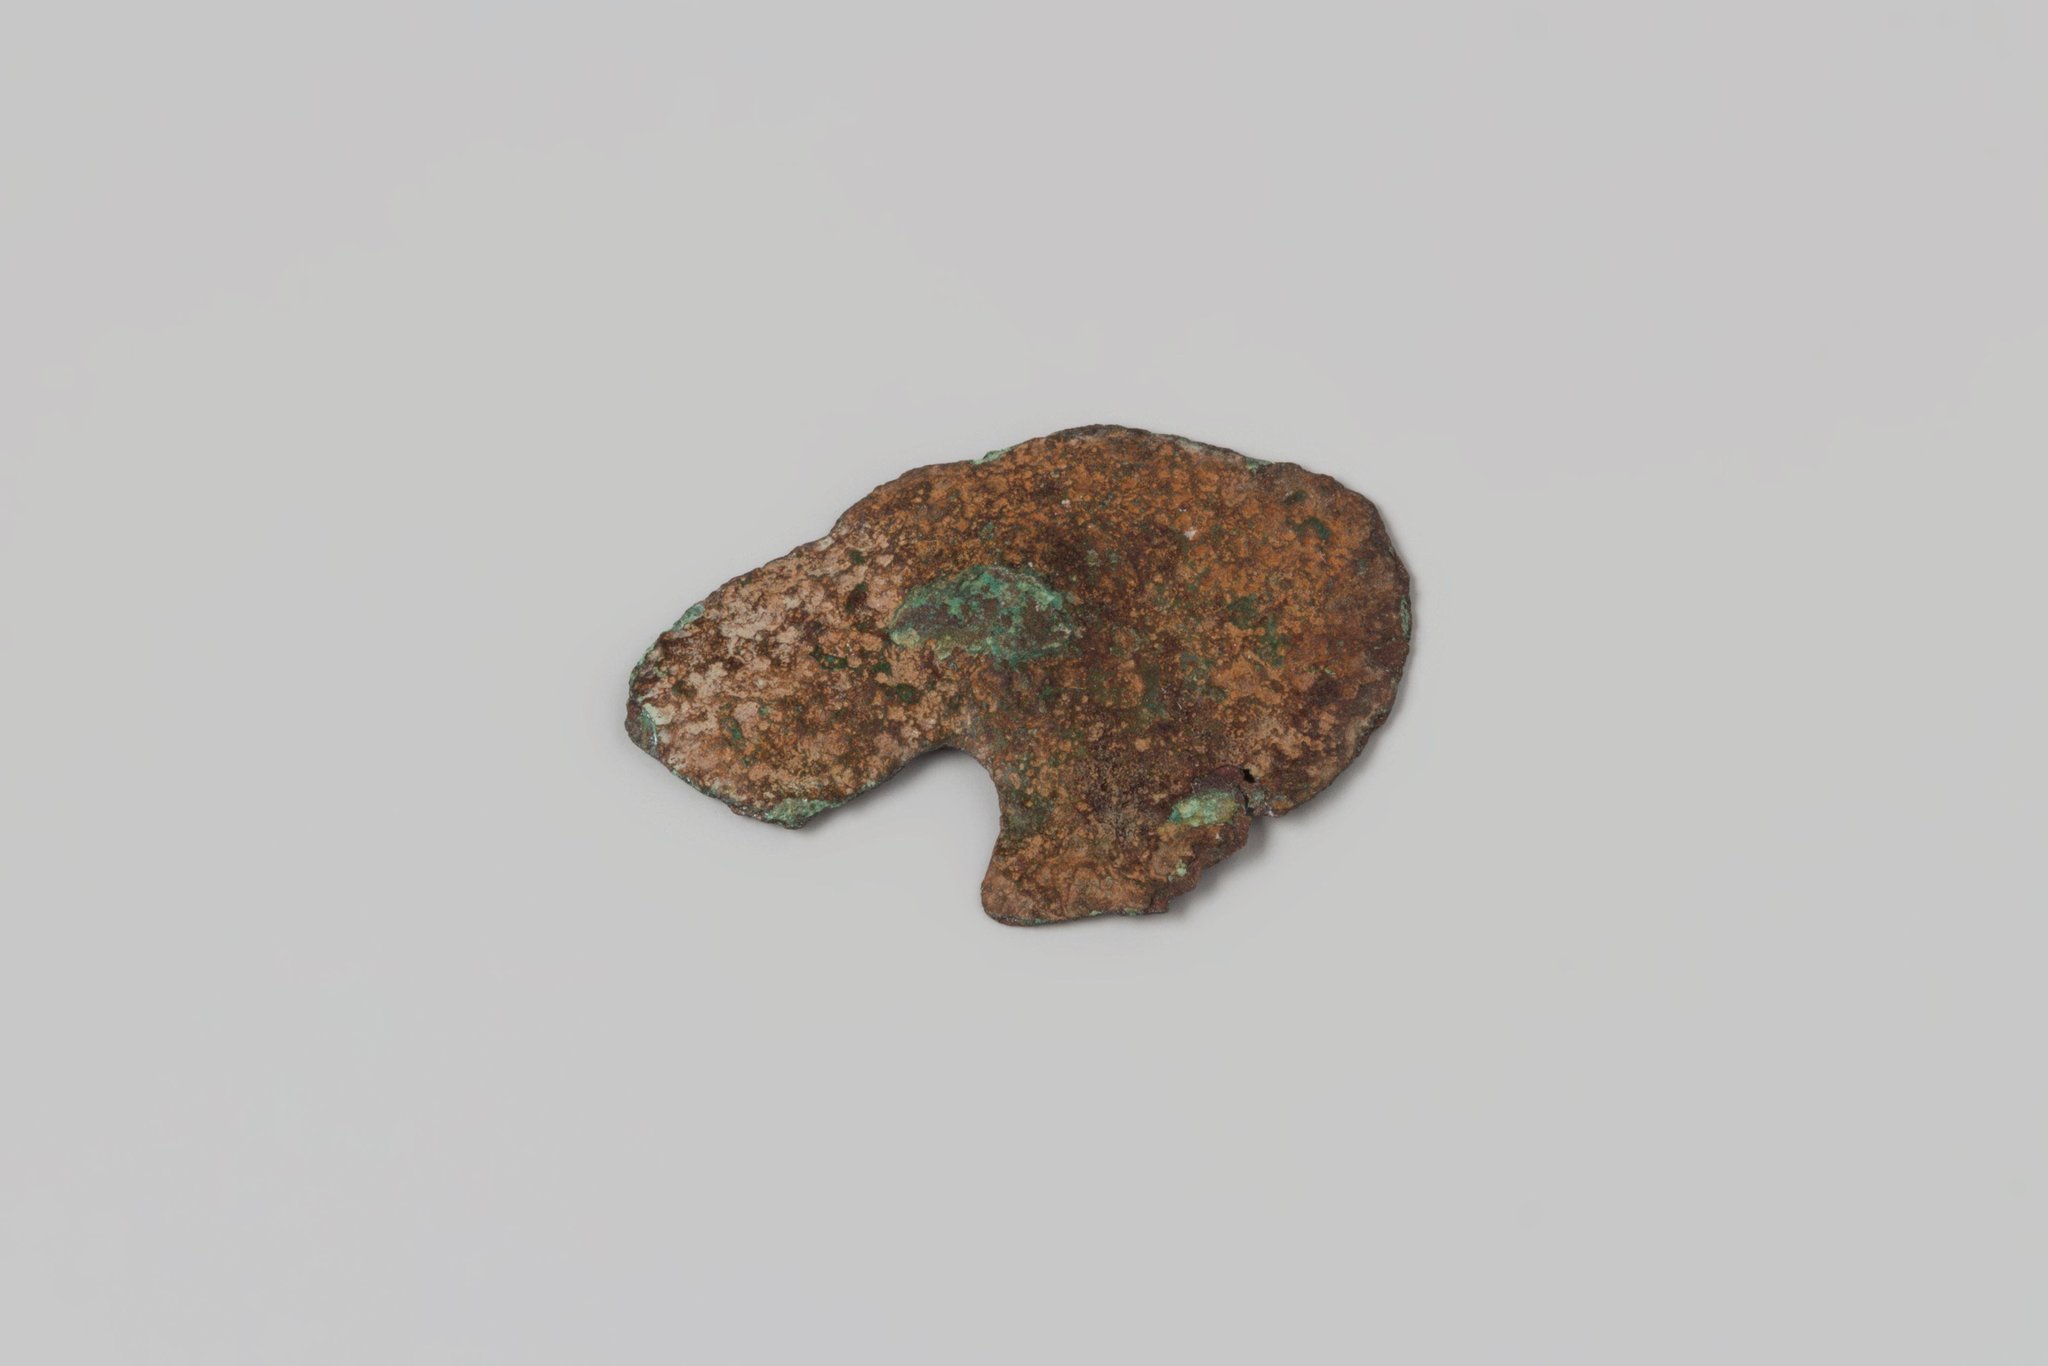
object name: scheepswrakvondst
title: Fragment van koper uit het wrak van de Oost-Indiëvaarder Hollandia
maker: Anonymous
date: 1700-1743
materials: copper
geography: netherlands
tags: verenigde oostindische compagnie, hollandia (schip), annet